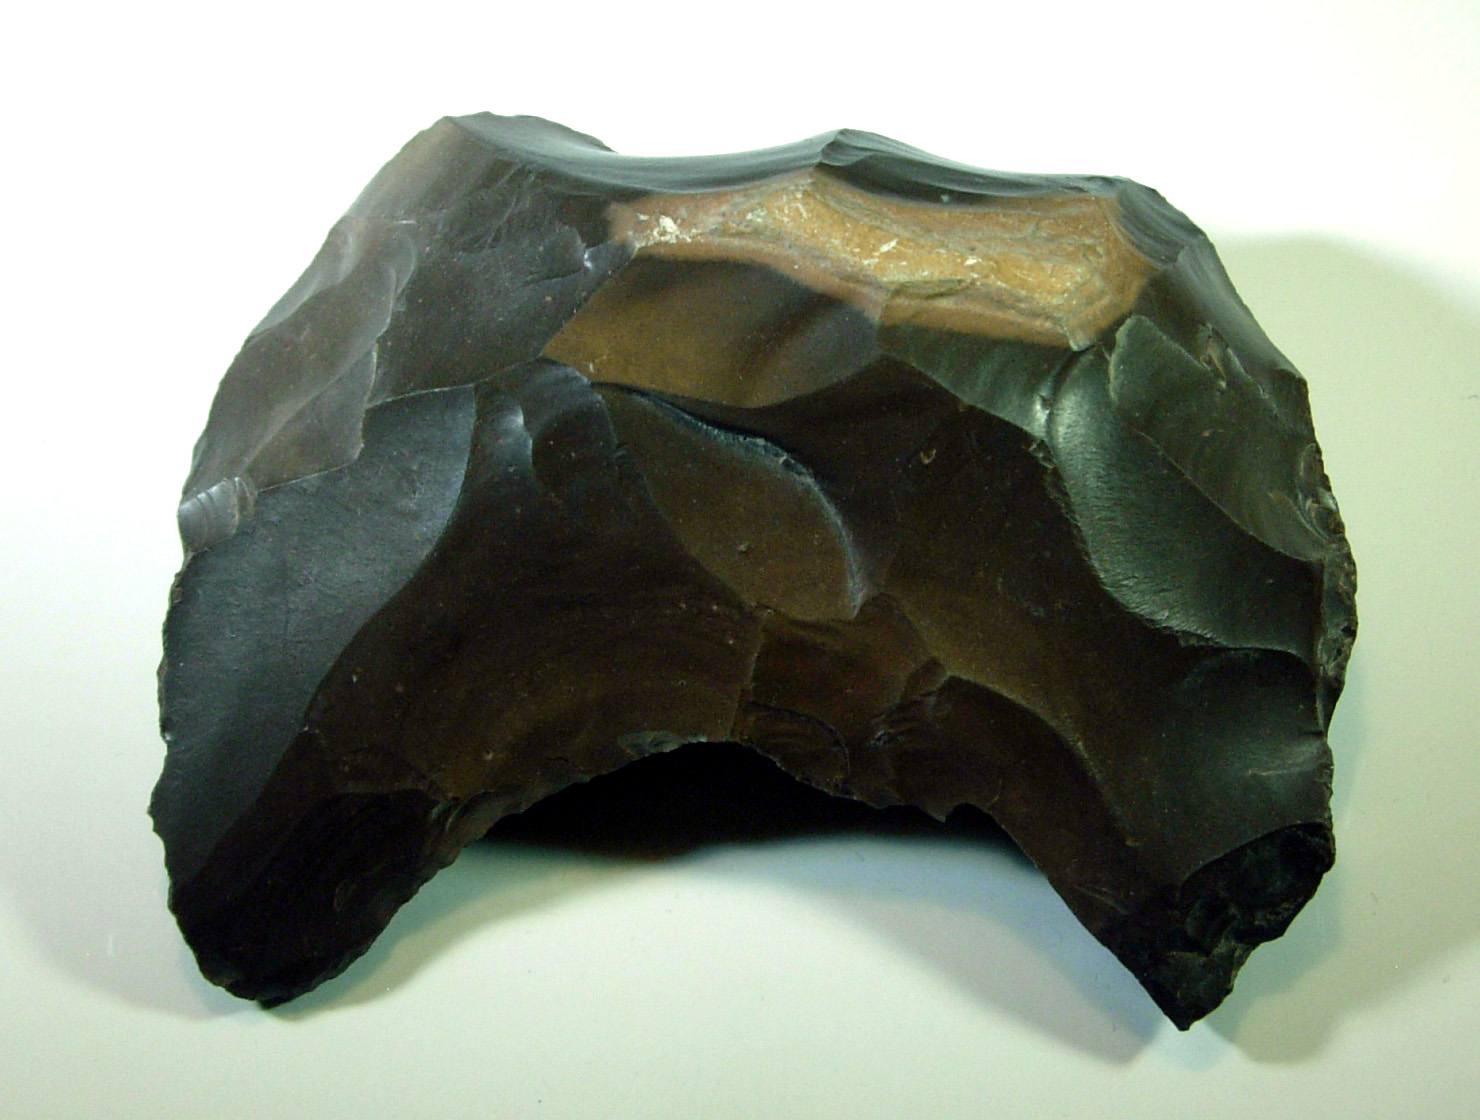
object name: tool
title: Tool (?)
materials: stone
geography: egypt